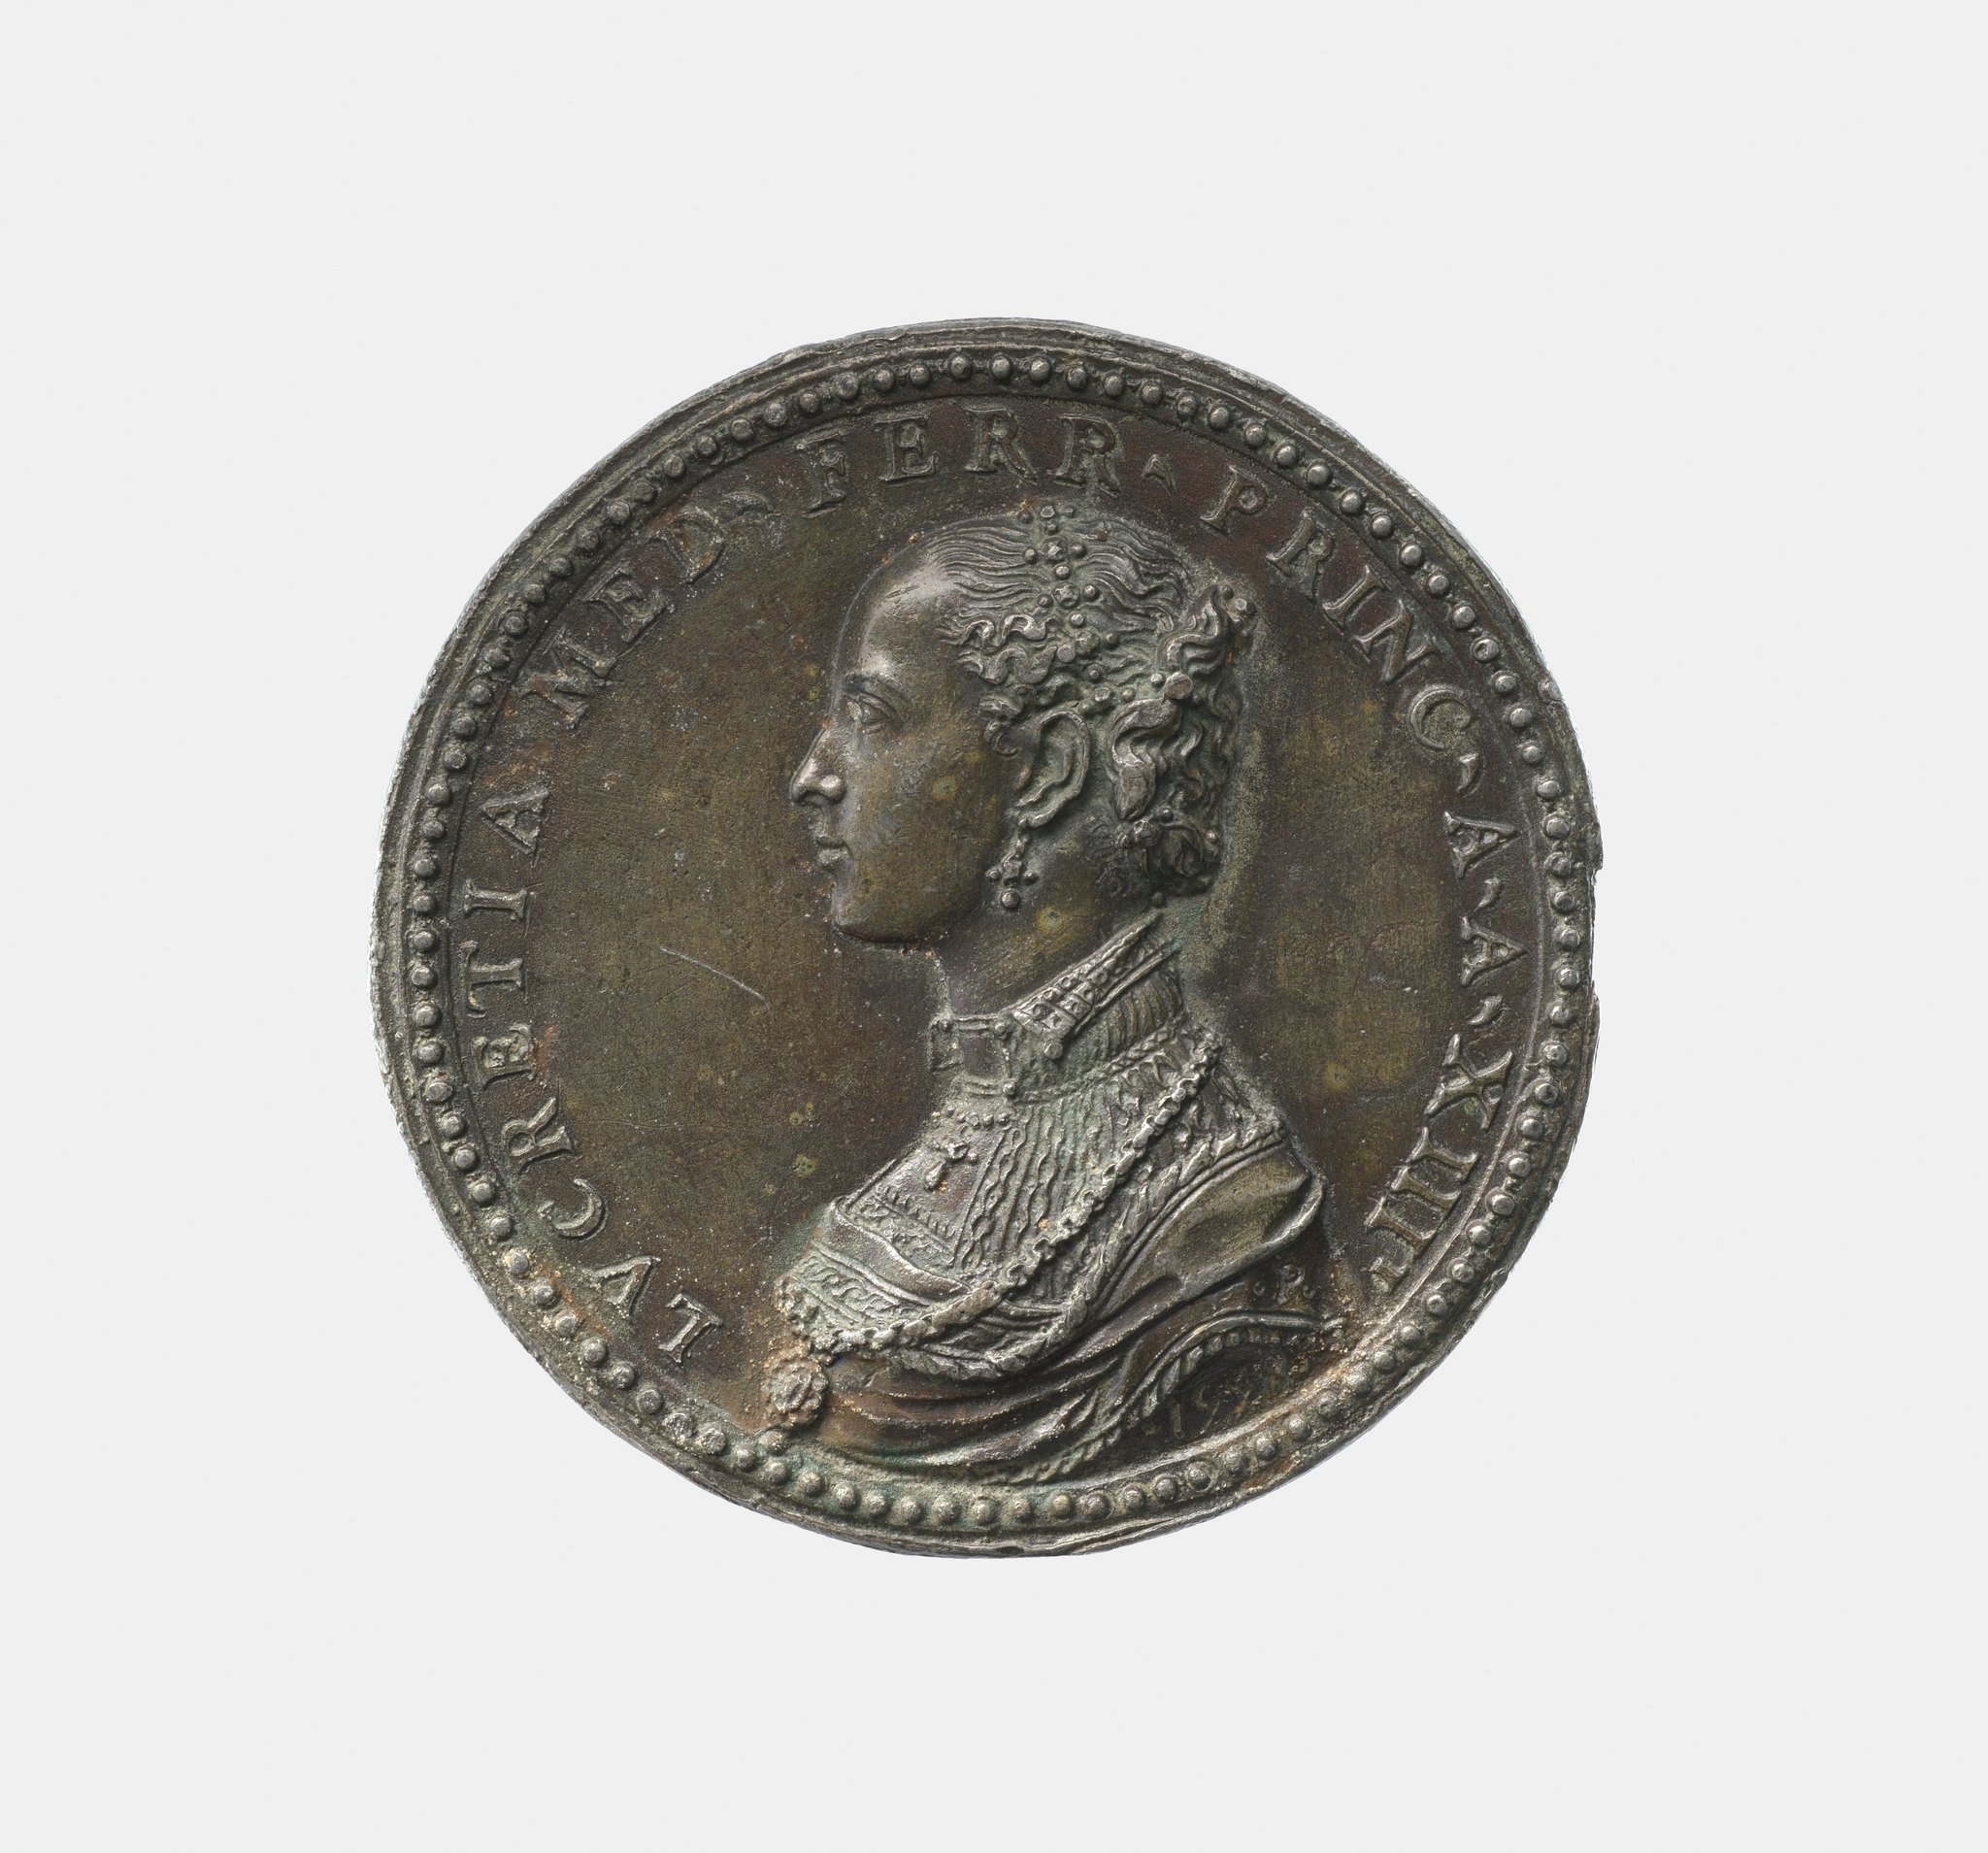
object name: medal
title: Lucrezia de' Medici 1545-61, first wife of Alfonso II d'Este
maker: pastorino di giovan michele de' pastorini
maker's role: artist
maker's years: 1508-1592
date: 1558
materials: lead